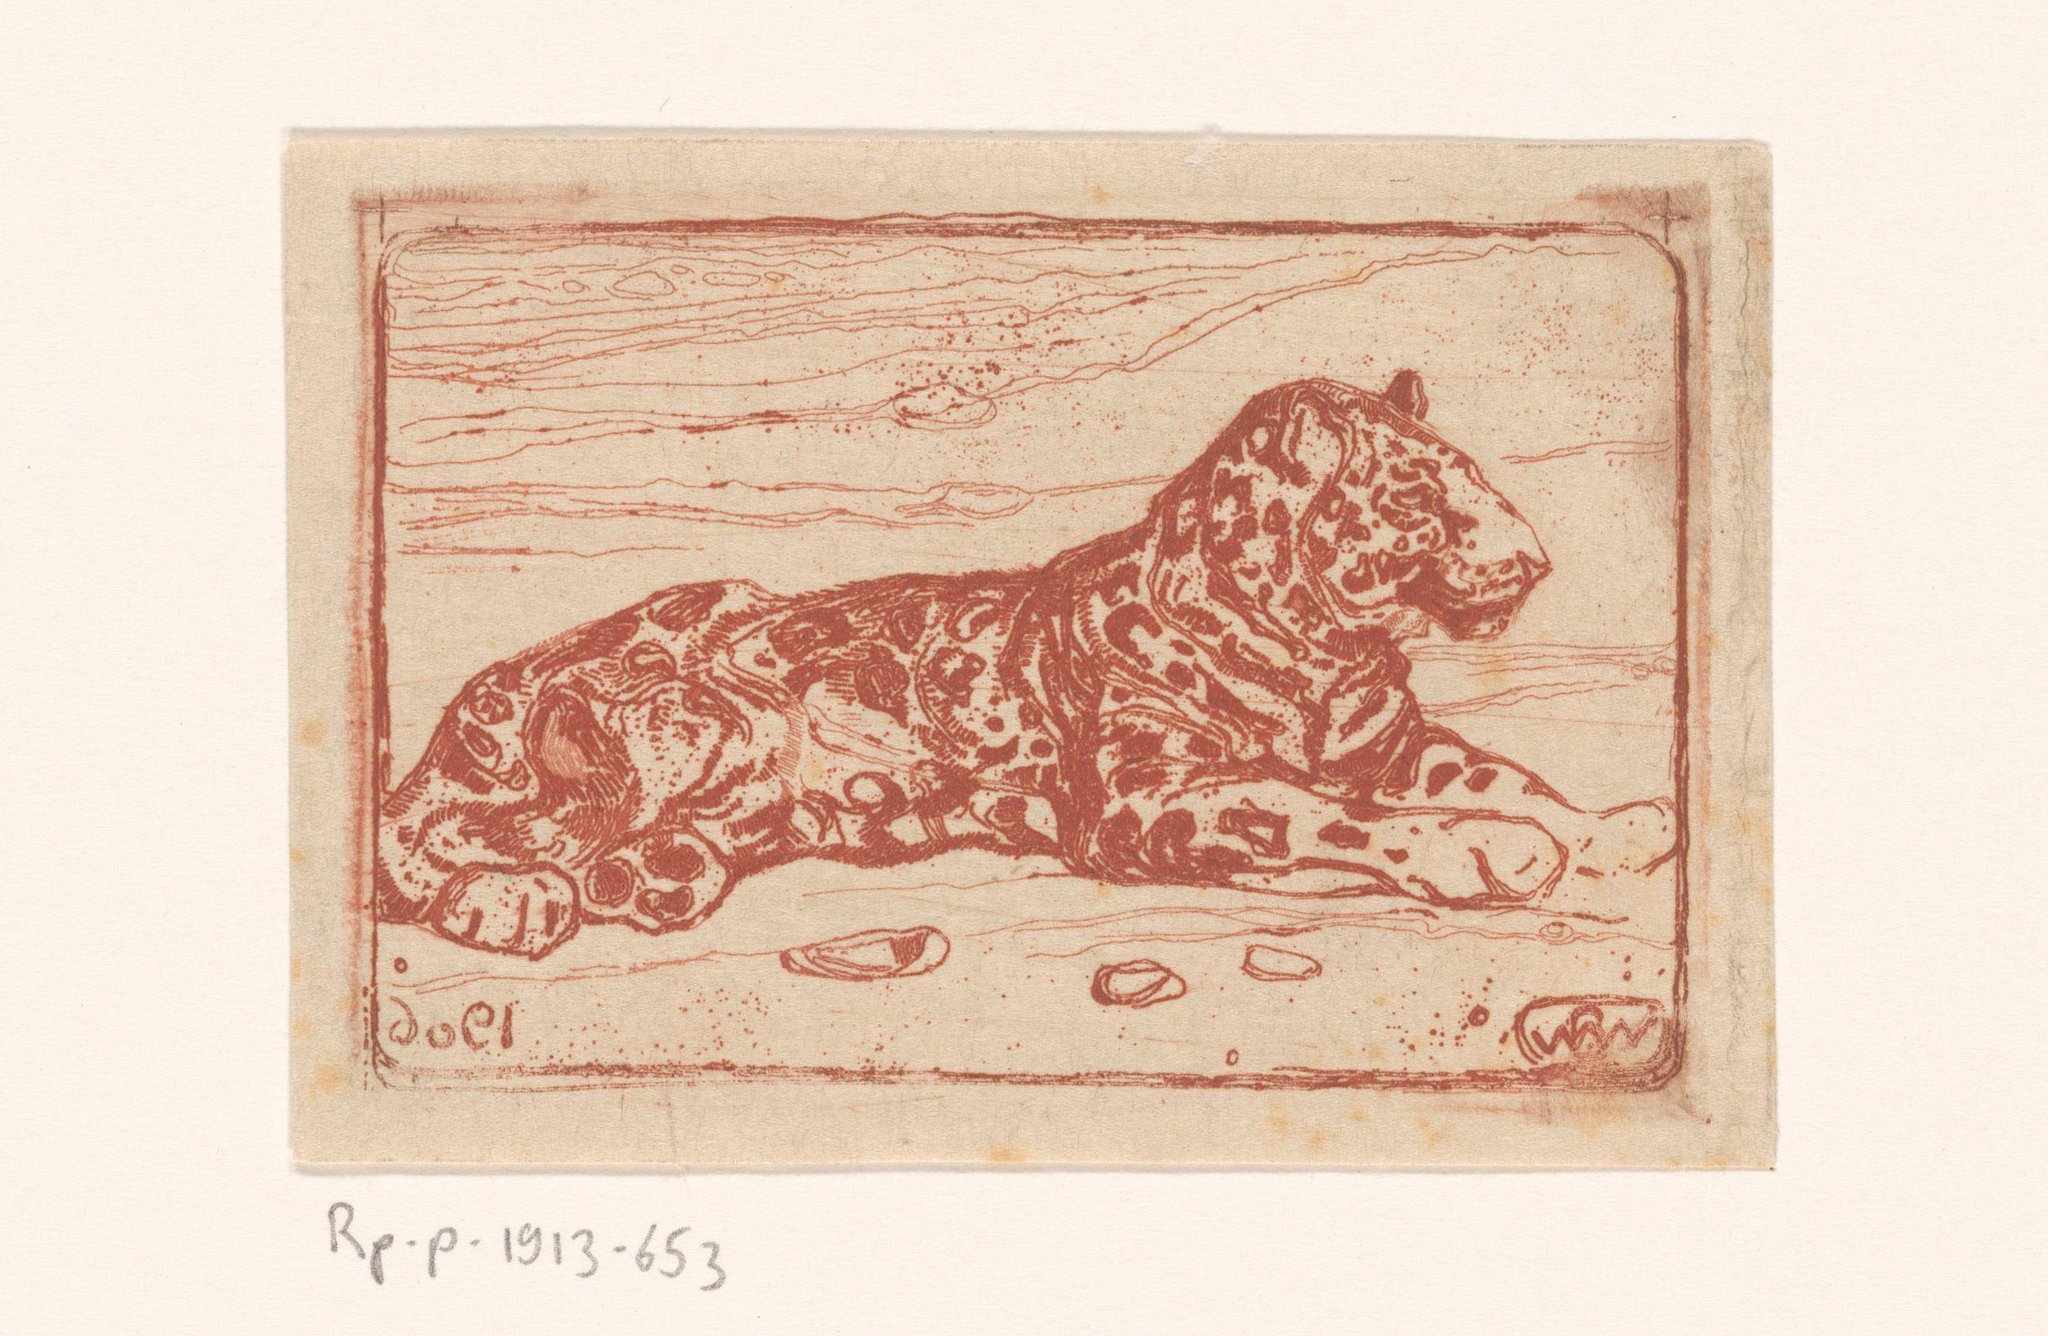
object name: print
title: Liggende panter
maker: bernard willem wierink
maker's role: draughtsman, print maker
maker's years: 1856-1939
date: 1906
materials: paper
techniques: etching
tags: beasts of prey, predatory animals: panther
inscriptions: collector's mark: Lugt 2233